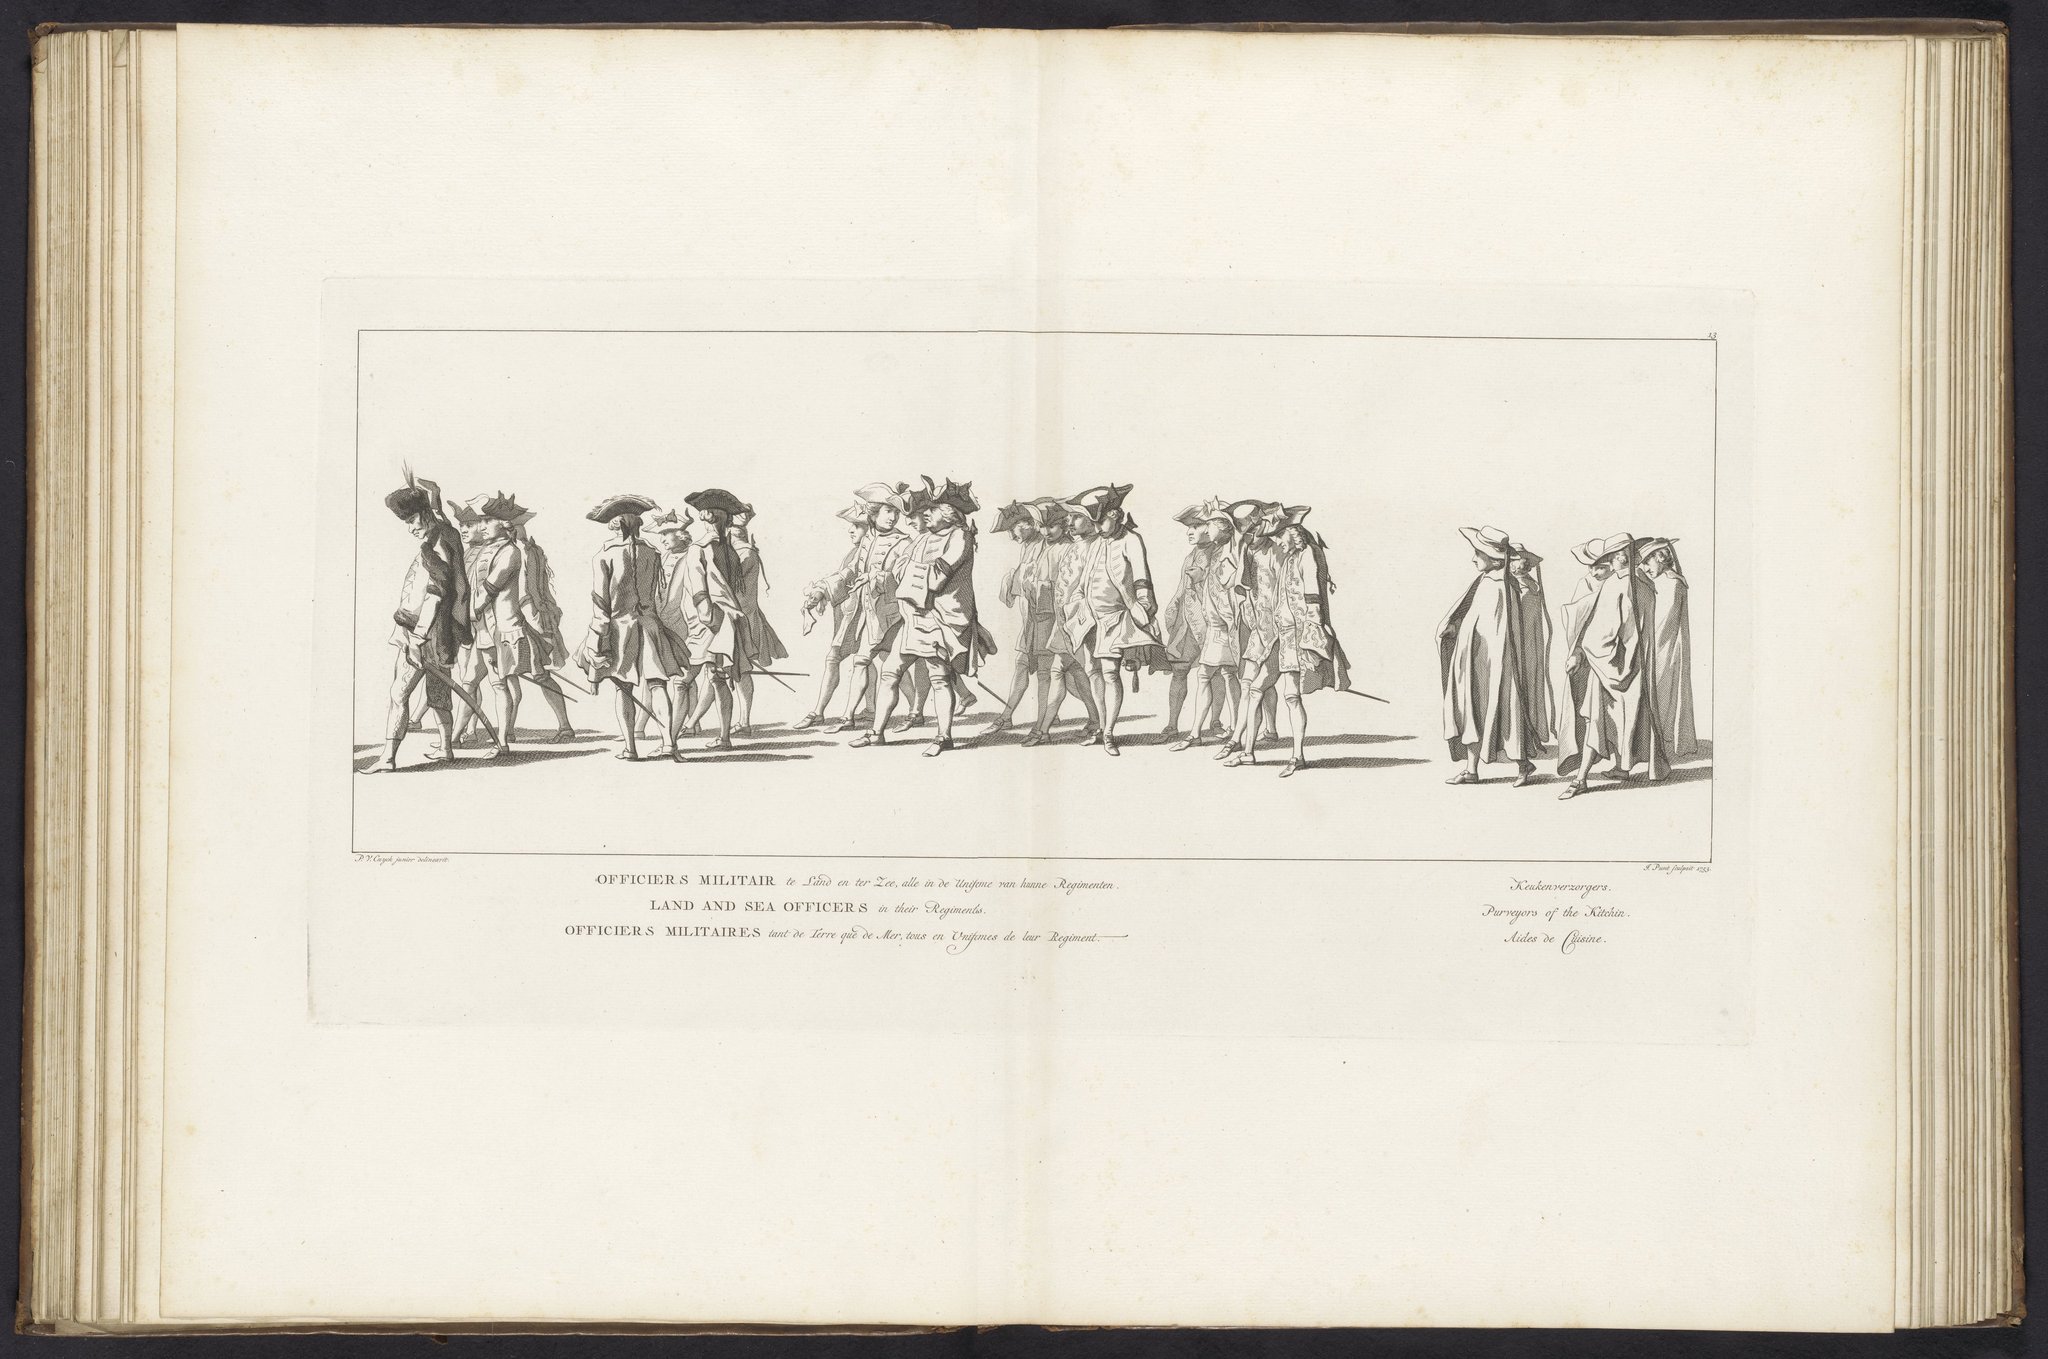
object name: print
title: Lyk-staetsie van zyne doorluchtigste Hoogheid den Heere Willem [IV] Carel Hendrik Friso, Prince van Orange en Nassau (...) gehouden den IV Februari 1752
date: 1753-1755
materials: paper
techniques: engraving, etching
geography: the hague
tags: willem iv (prins van oranje-nassau), cortege, funeral procession, military parade, pageant, delft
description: Militaire officieren en keukenpersoneel. In de marge het onderschrift in Nederlands, Frans en Engels. Onderdeel van een serie van 41 platen van de begrafenisstoet van stadhouder Willem IV te Delft op 4 februari 1752. Genummerd rechtsboven: 13. In de gebonden uitgave van 1755.